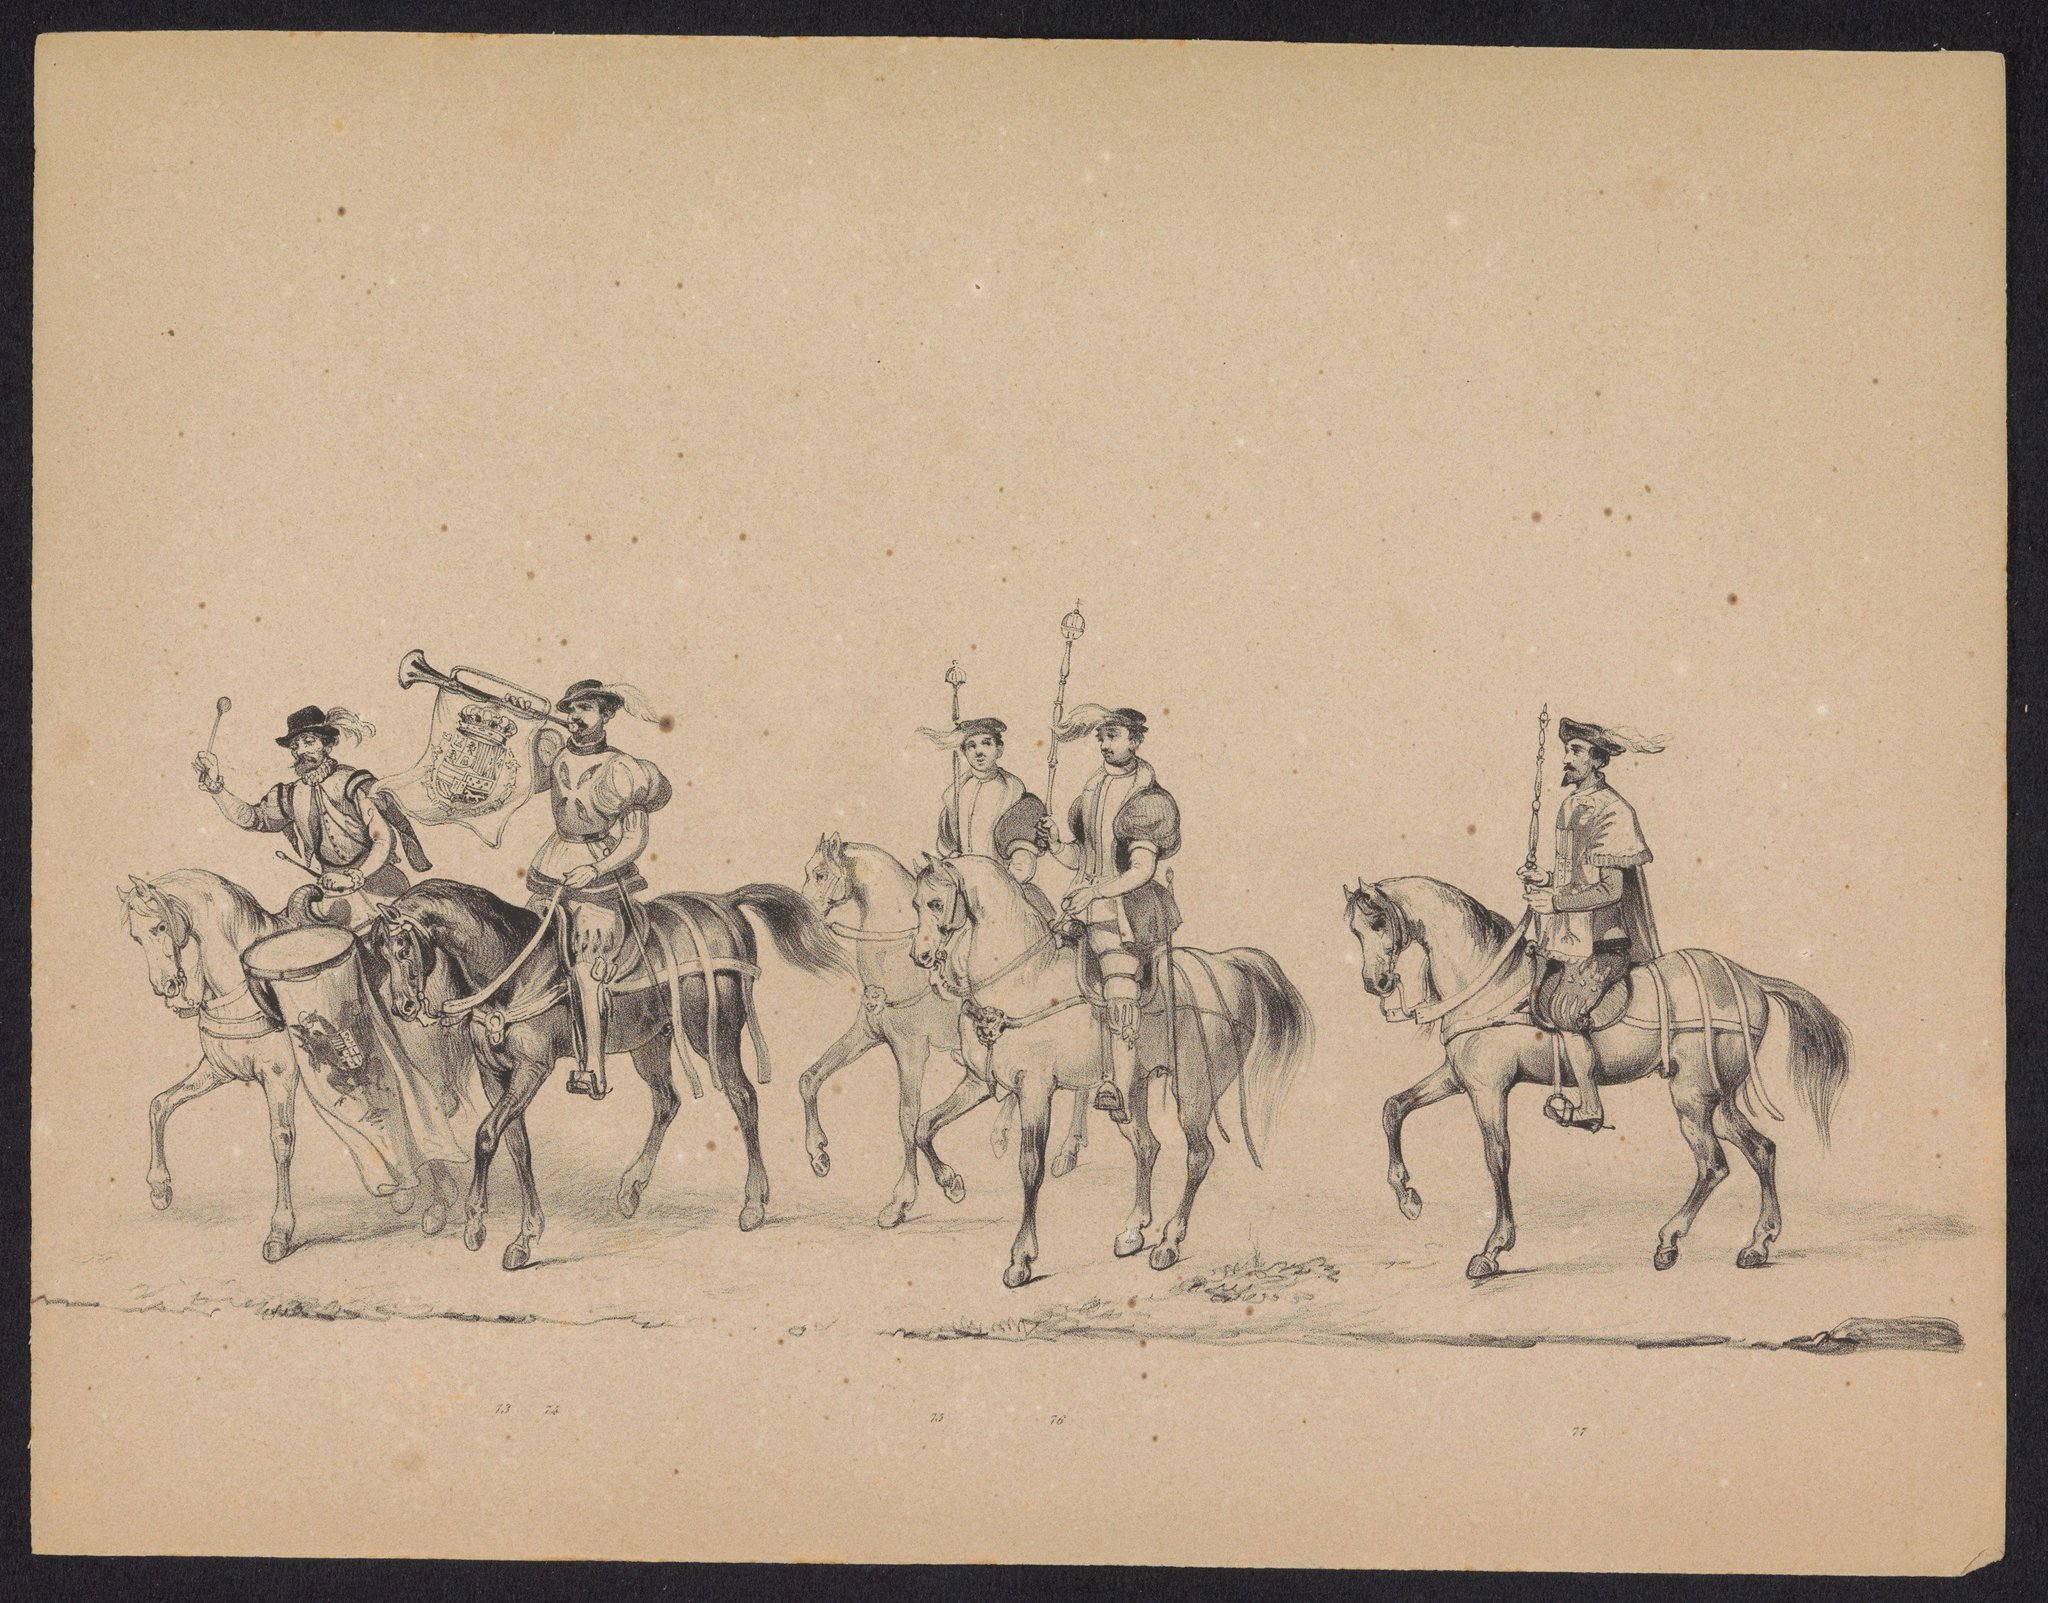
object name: print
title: Maskerade van de Utrechtse studenten, 1846 (plaat 13)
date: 1847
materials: paper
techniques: lithograph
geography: netherlands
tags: philip ii of spain, students' pageant, costumes used in pageants, utrecht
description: Historische gekostumeerde optocht van de studenten van de Utrechtse Hogeschool gehouden op 17 juni 1846 ter gelegenheid van het 210-jarig bestaan van de Hogeschool. De optocht verbeeldt de intocht van Filips II in Utrecht op 3 oktober 1549. Plaat met de groepen genummerd 73-77. Onderdeel van de serie van 22 aanelkaar te plakken losse bladen.